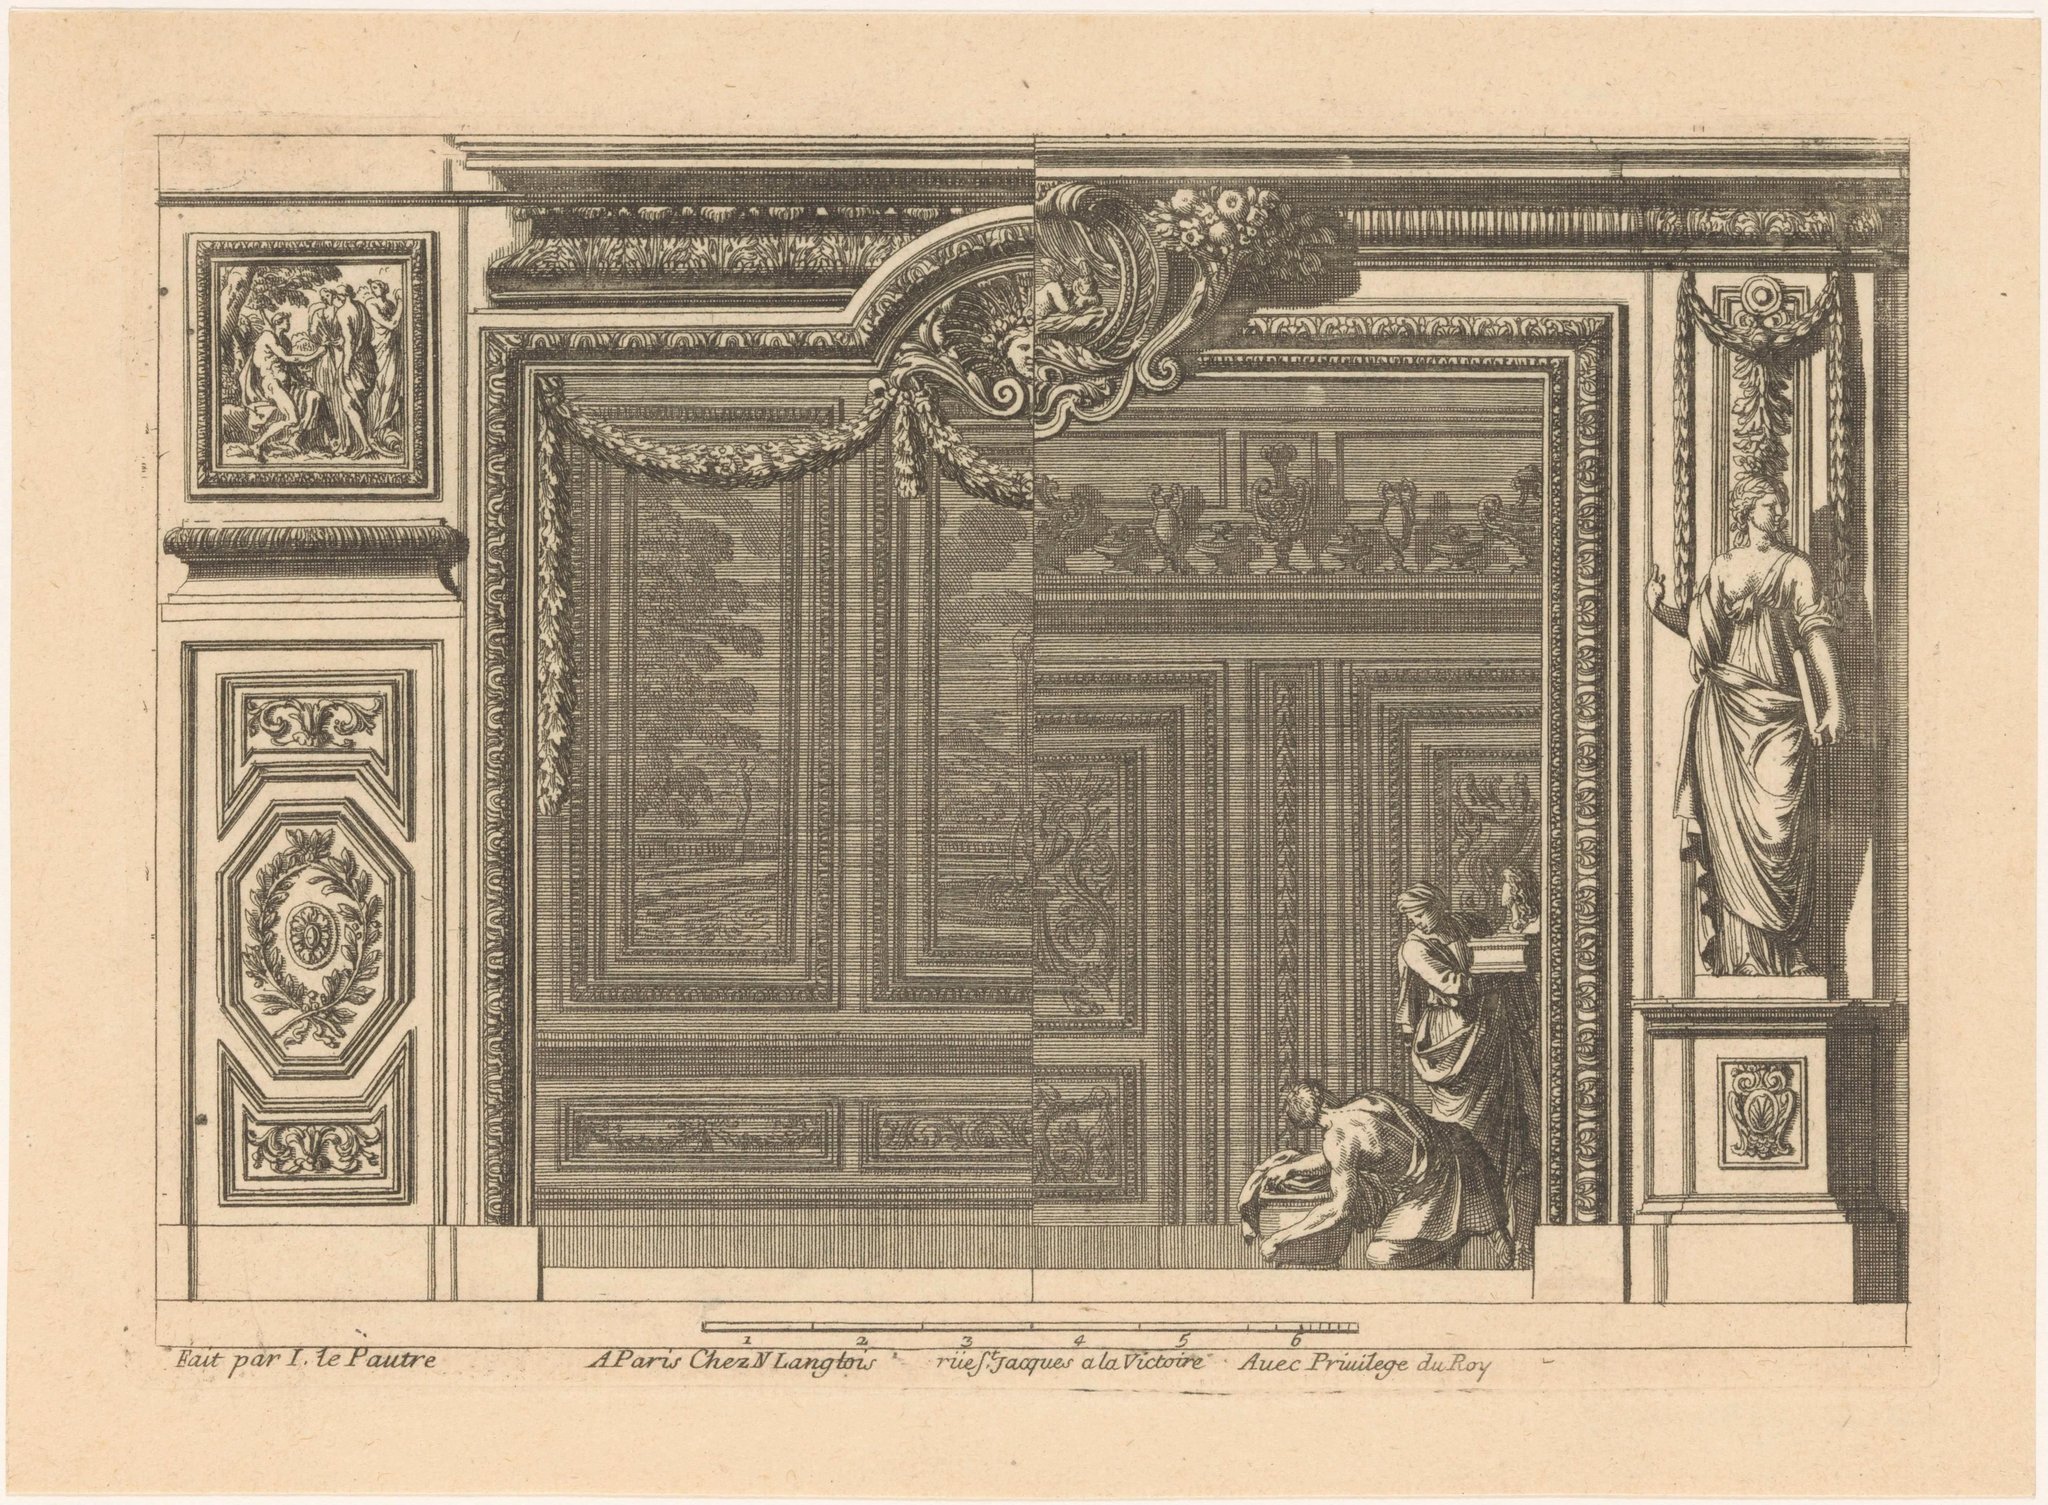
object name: ornament print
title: Alkoof met variant voor rechterhelft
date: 1678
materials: paper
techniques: etching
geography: paris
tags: interior of the house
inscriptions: collector's mark: Lugt 2228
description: Alkoof met links een deur met dessus-de-porte met figuren. De rechterkant is een variant met een beeld van een vrouw op een voetstuk.